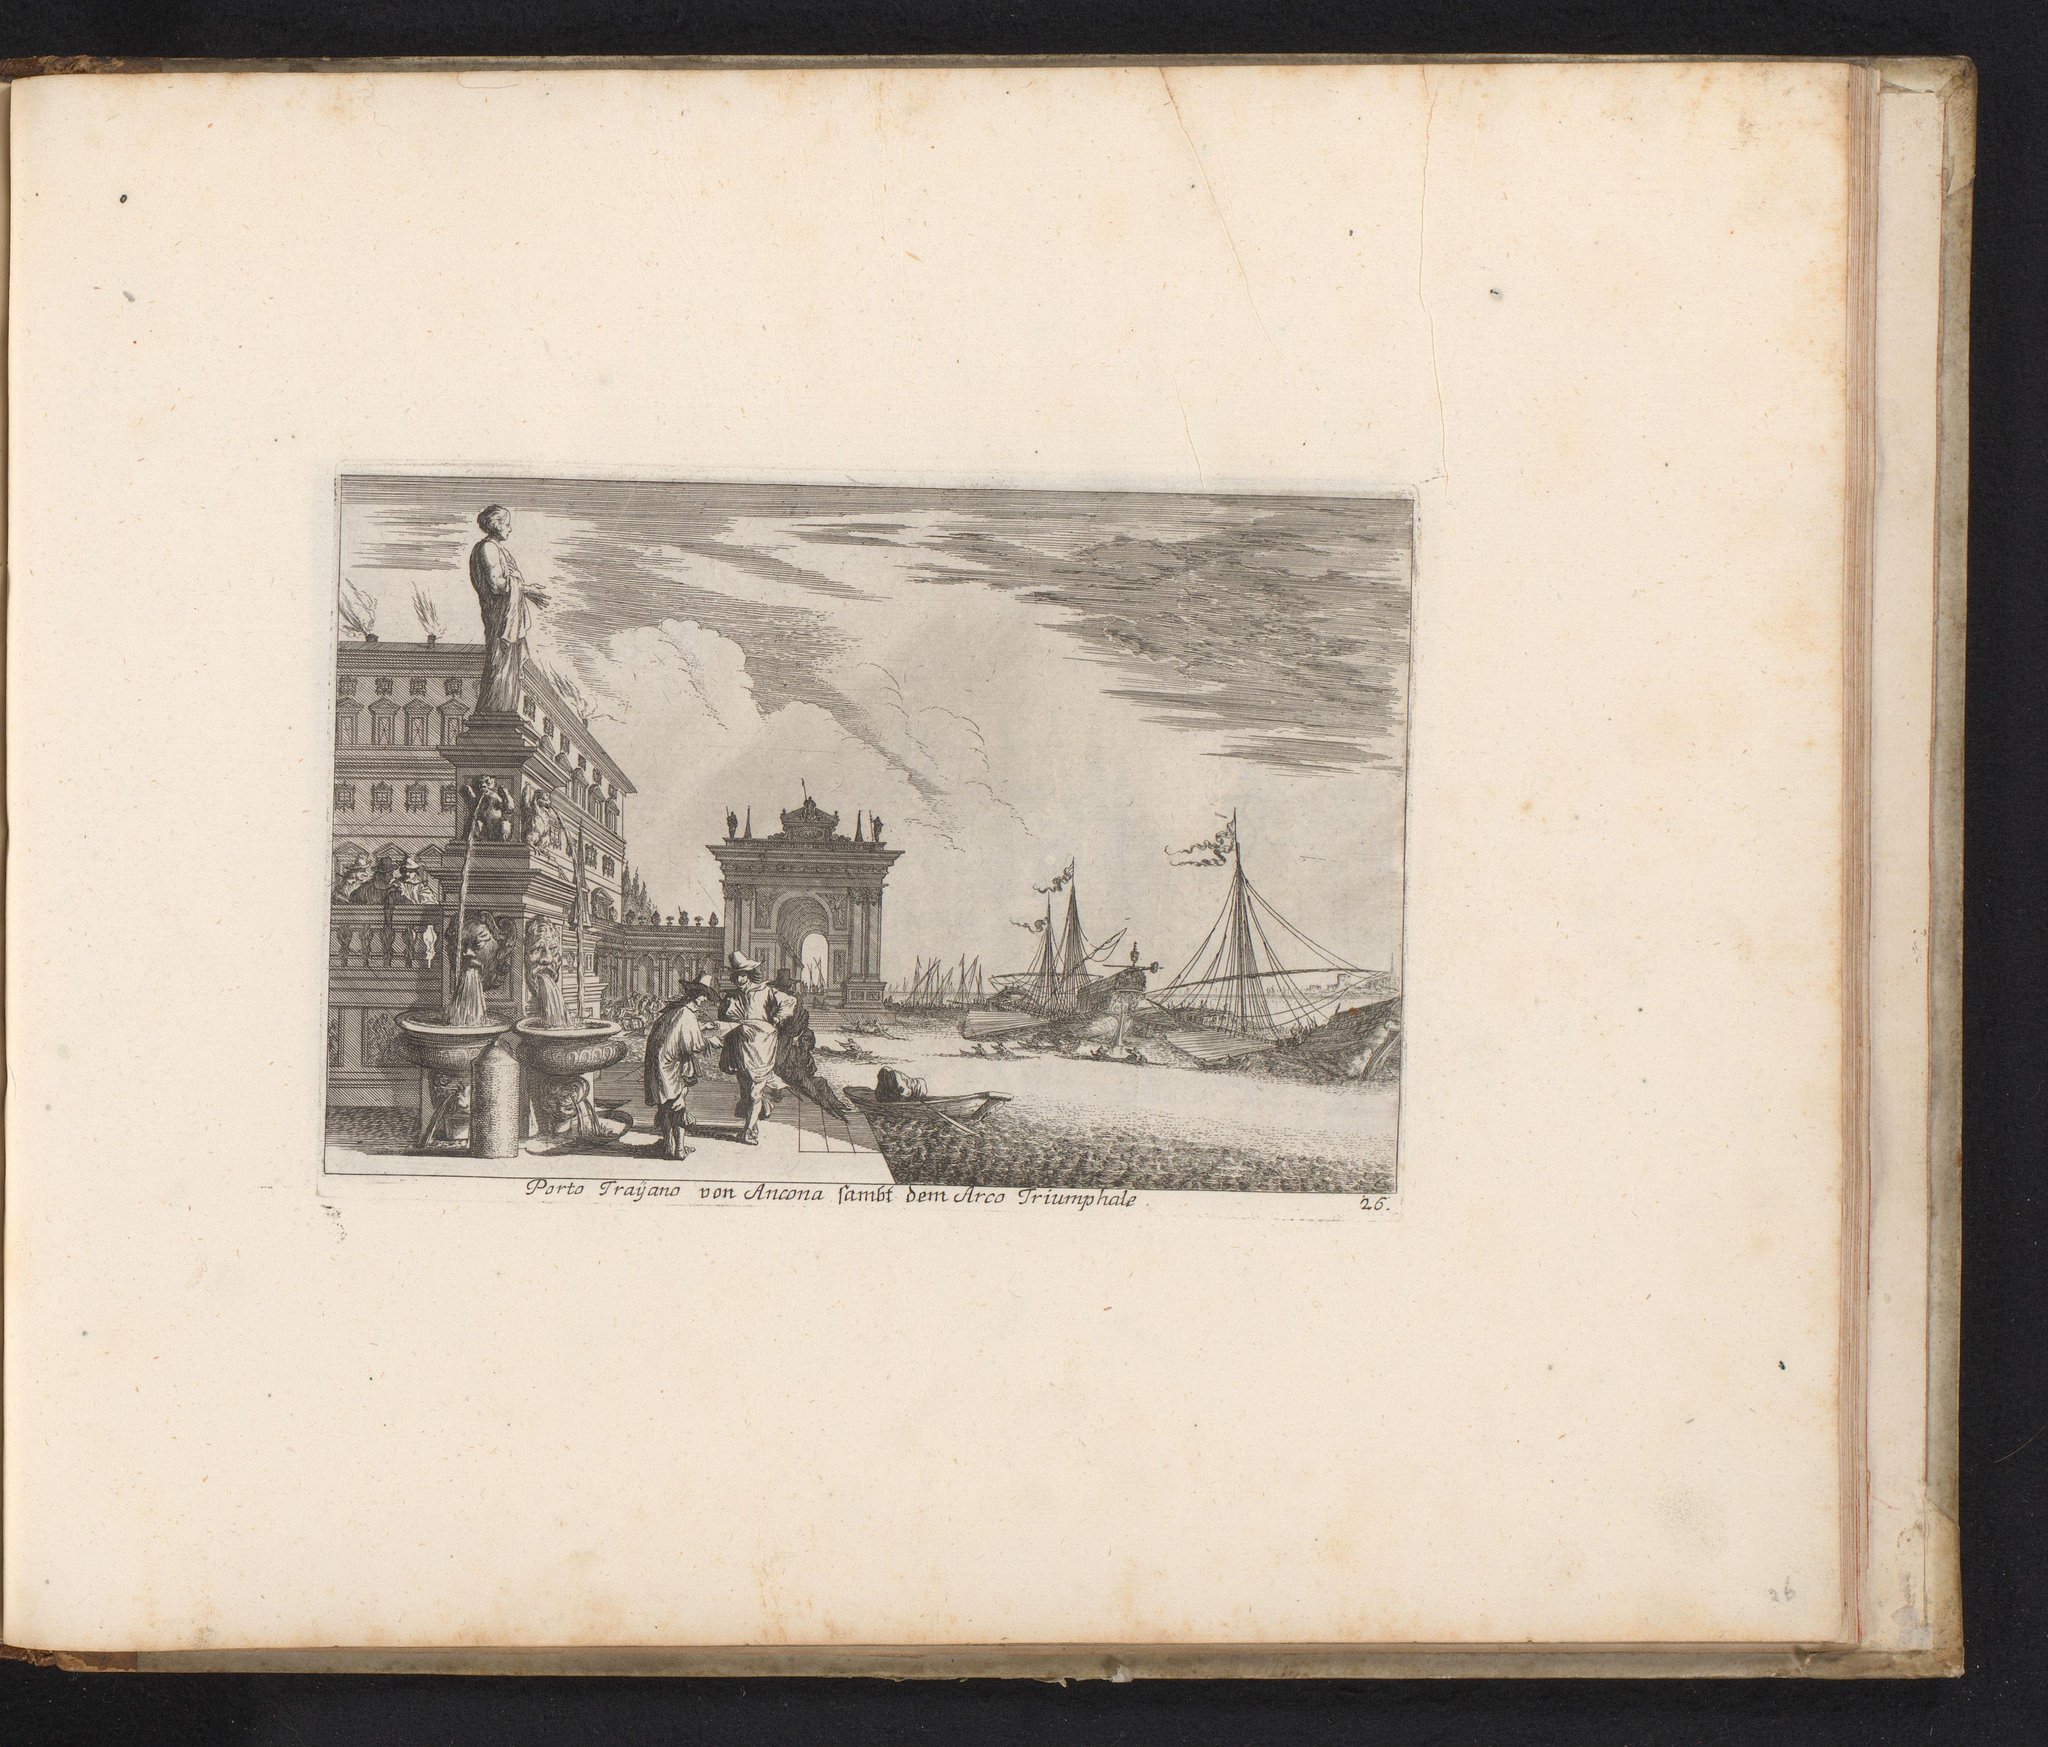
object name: album leaf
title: Triomfboog van Trajanus in de haven van Ancona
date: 1670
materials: paper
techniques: etching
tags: triumphal arch, pier, quay, wharf (+ four persons or more ~ traffic and transport), monument, statue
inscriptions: collector's mark: Lugt 2228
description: Tekst in het Duits in de ondermarge. Rechtsonder genummerd: 26. Prent maakt deel uit van een album.